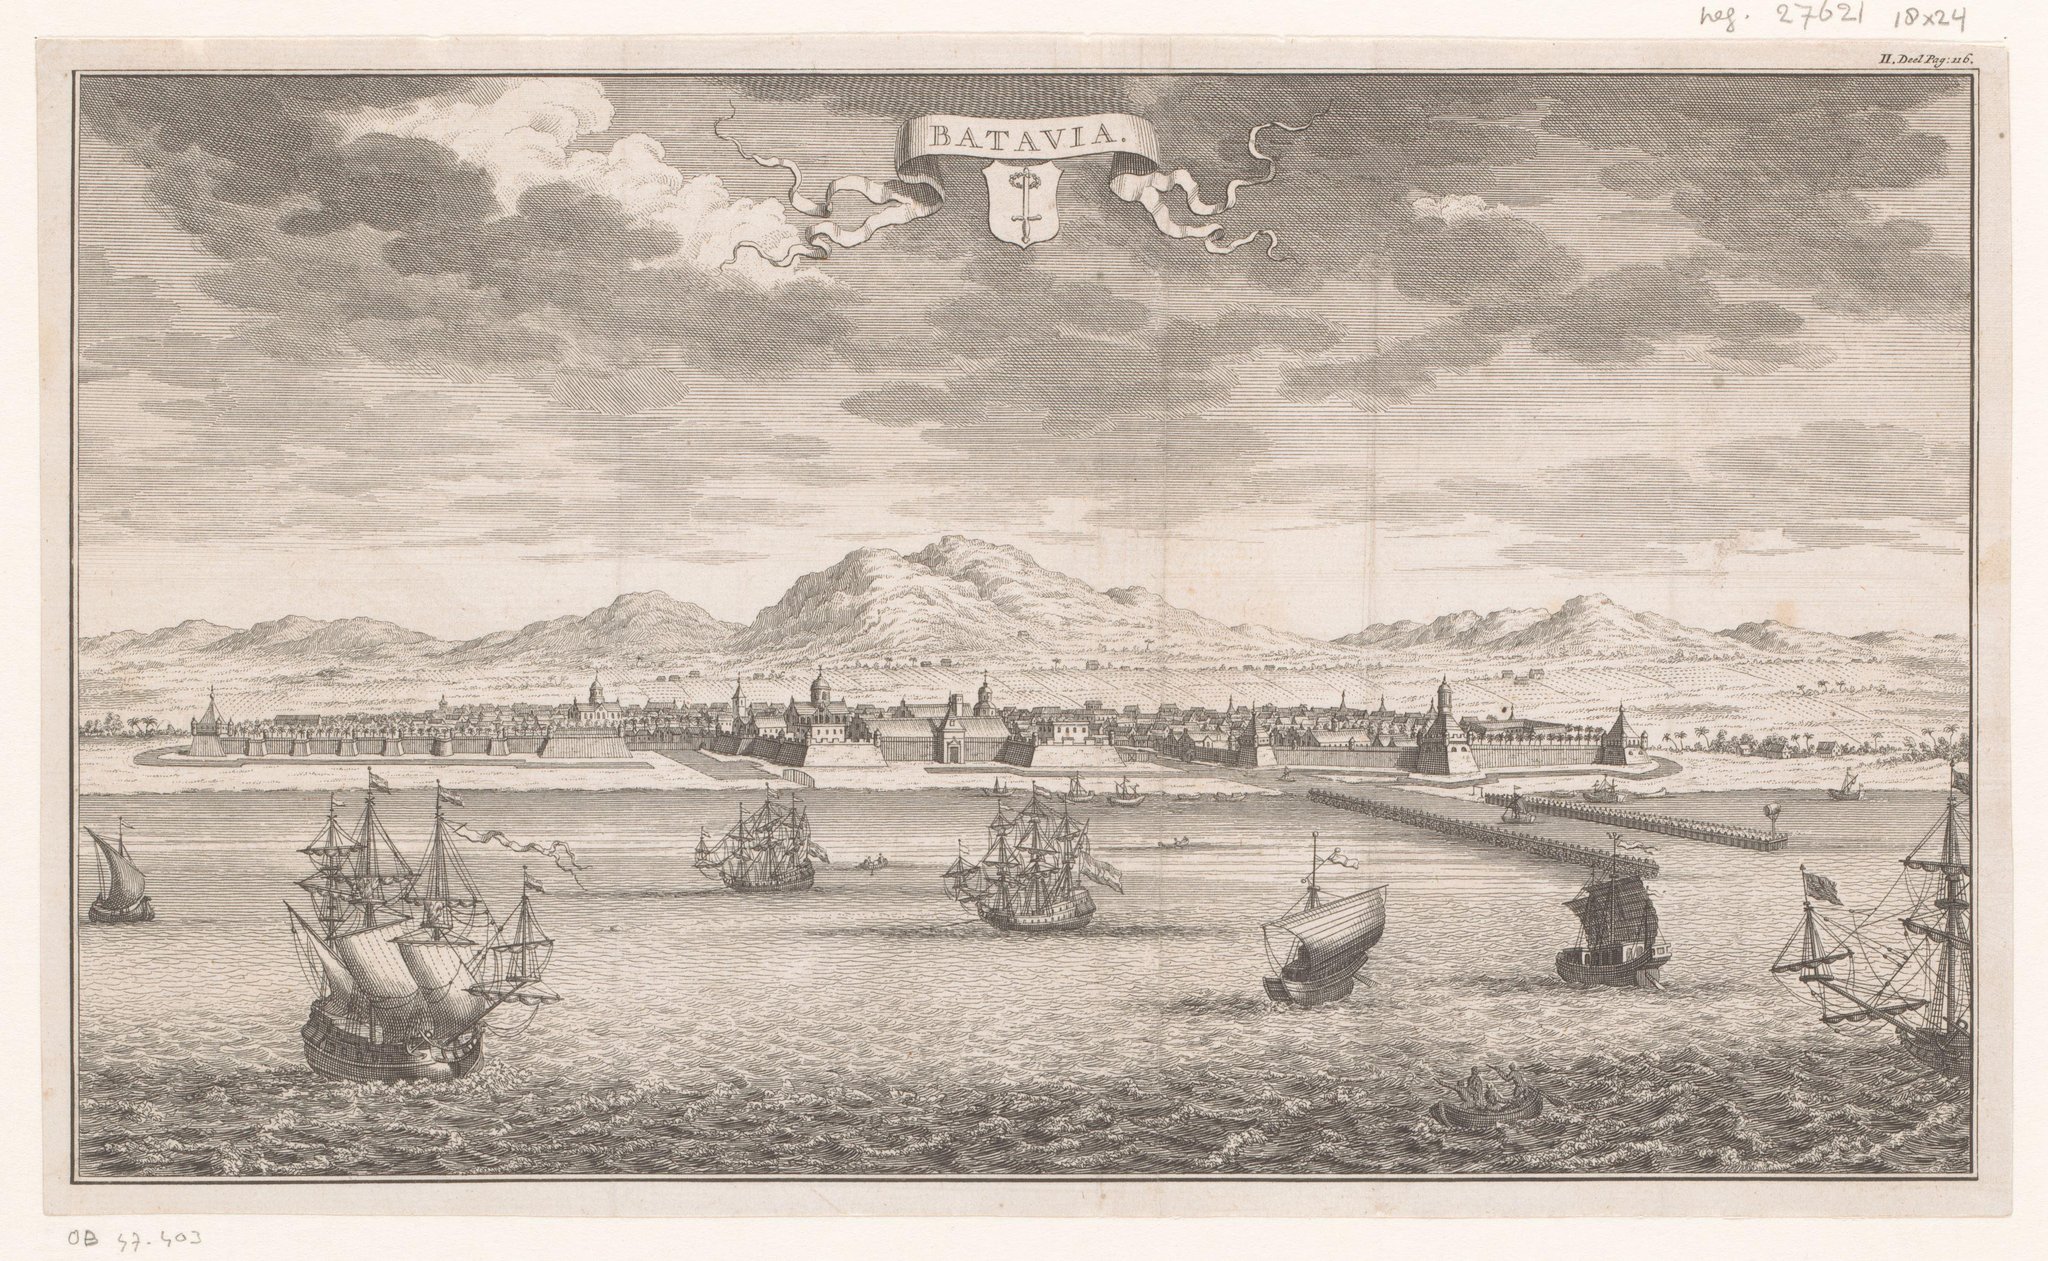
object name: print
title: Gezicht op Batavia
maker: Anonymous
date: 1700-1799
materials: paper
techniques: engraving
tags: island (in tropical and sub-tropical regions), batavia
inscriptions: collector's mark: Lugt 2228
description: Gezicht in vogelvlucht op Batavia, vanuit zee. Schepen, waaronder VOC-zeilschepen, op de voorgrond. De titel in een banier bovenin, met daaronder het wapen van Batavia. Rechts bovenin: II. Deel Pag. 116.